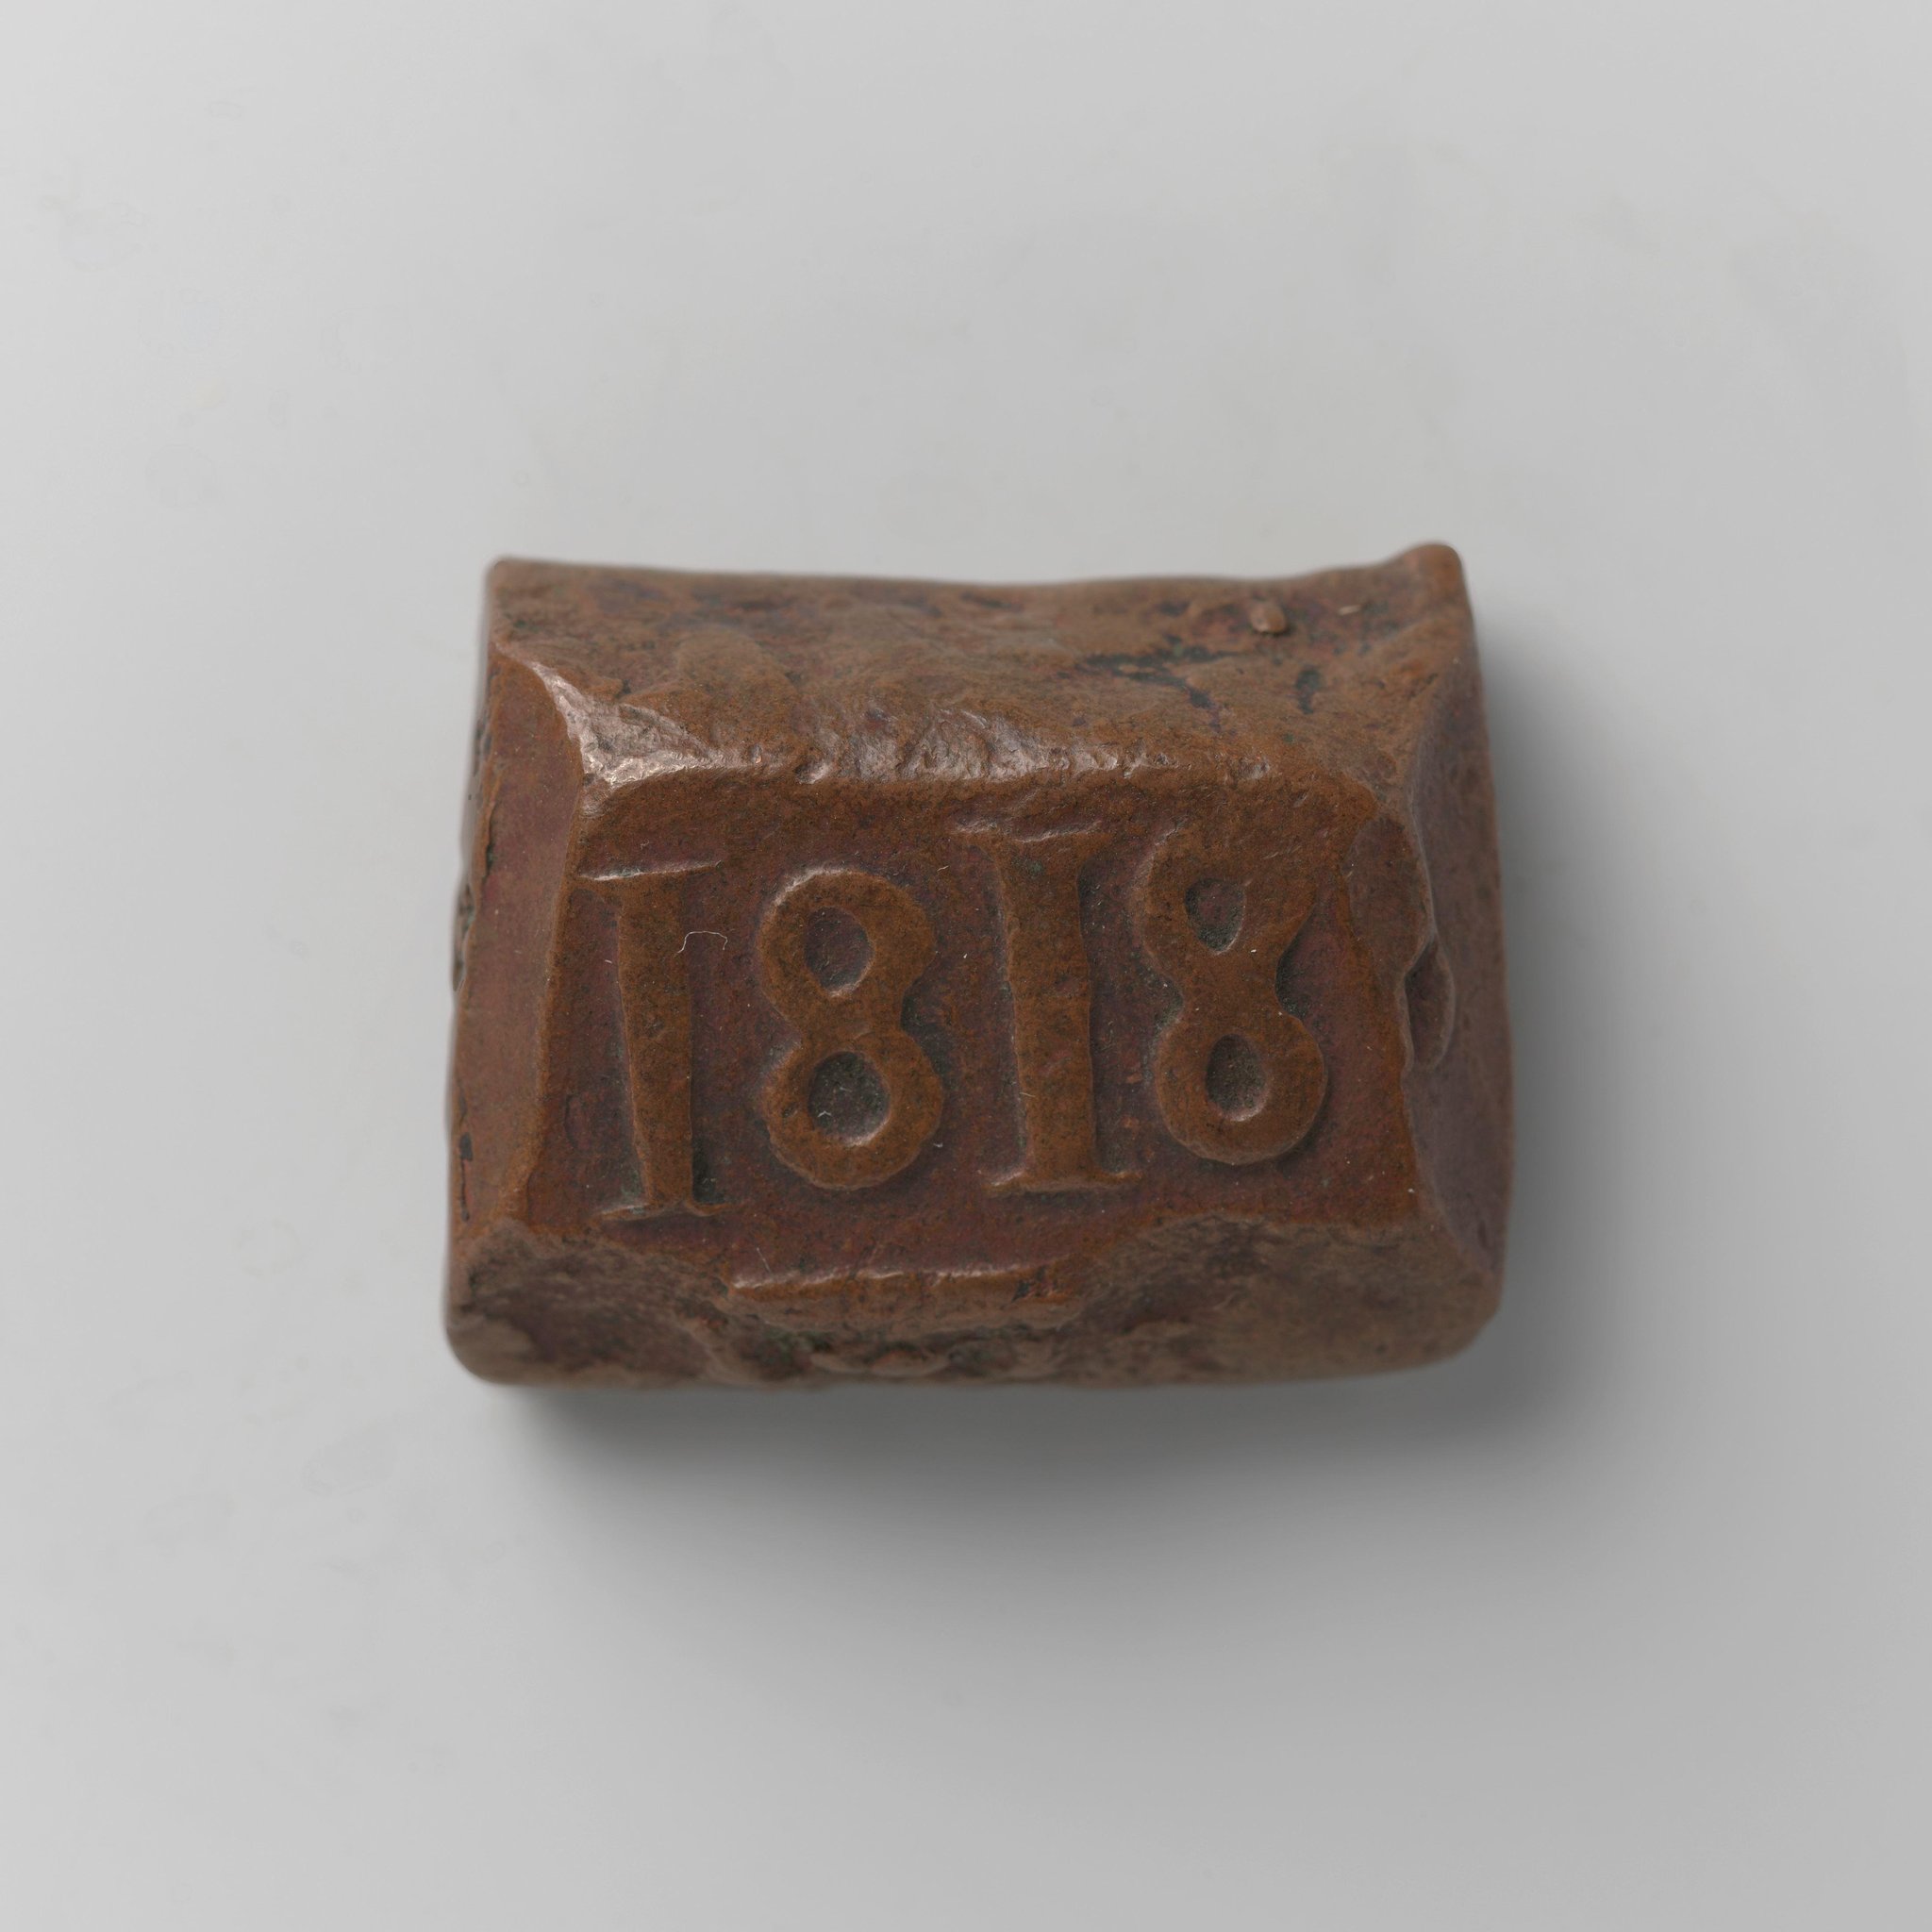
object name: coin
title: Nederlands Indië, 2 stuiver bonk,1818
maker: william i of the netherlands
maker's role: koning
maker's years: 1772-1843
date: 1818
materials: copper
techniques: striking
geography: surabaya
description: Koperen rechthoekige munt. Voorzijde: binnen een rechthoekige lijst waarde-aanduiding 2 St. Keerzijde: binnen een rechthoekige lijst jaartal.